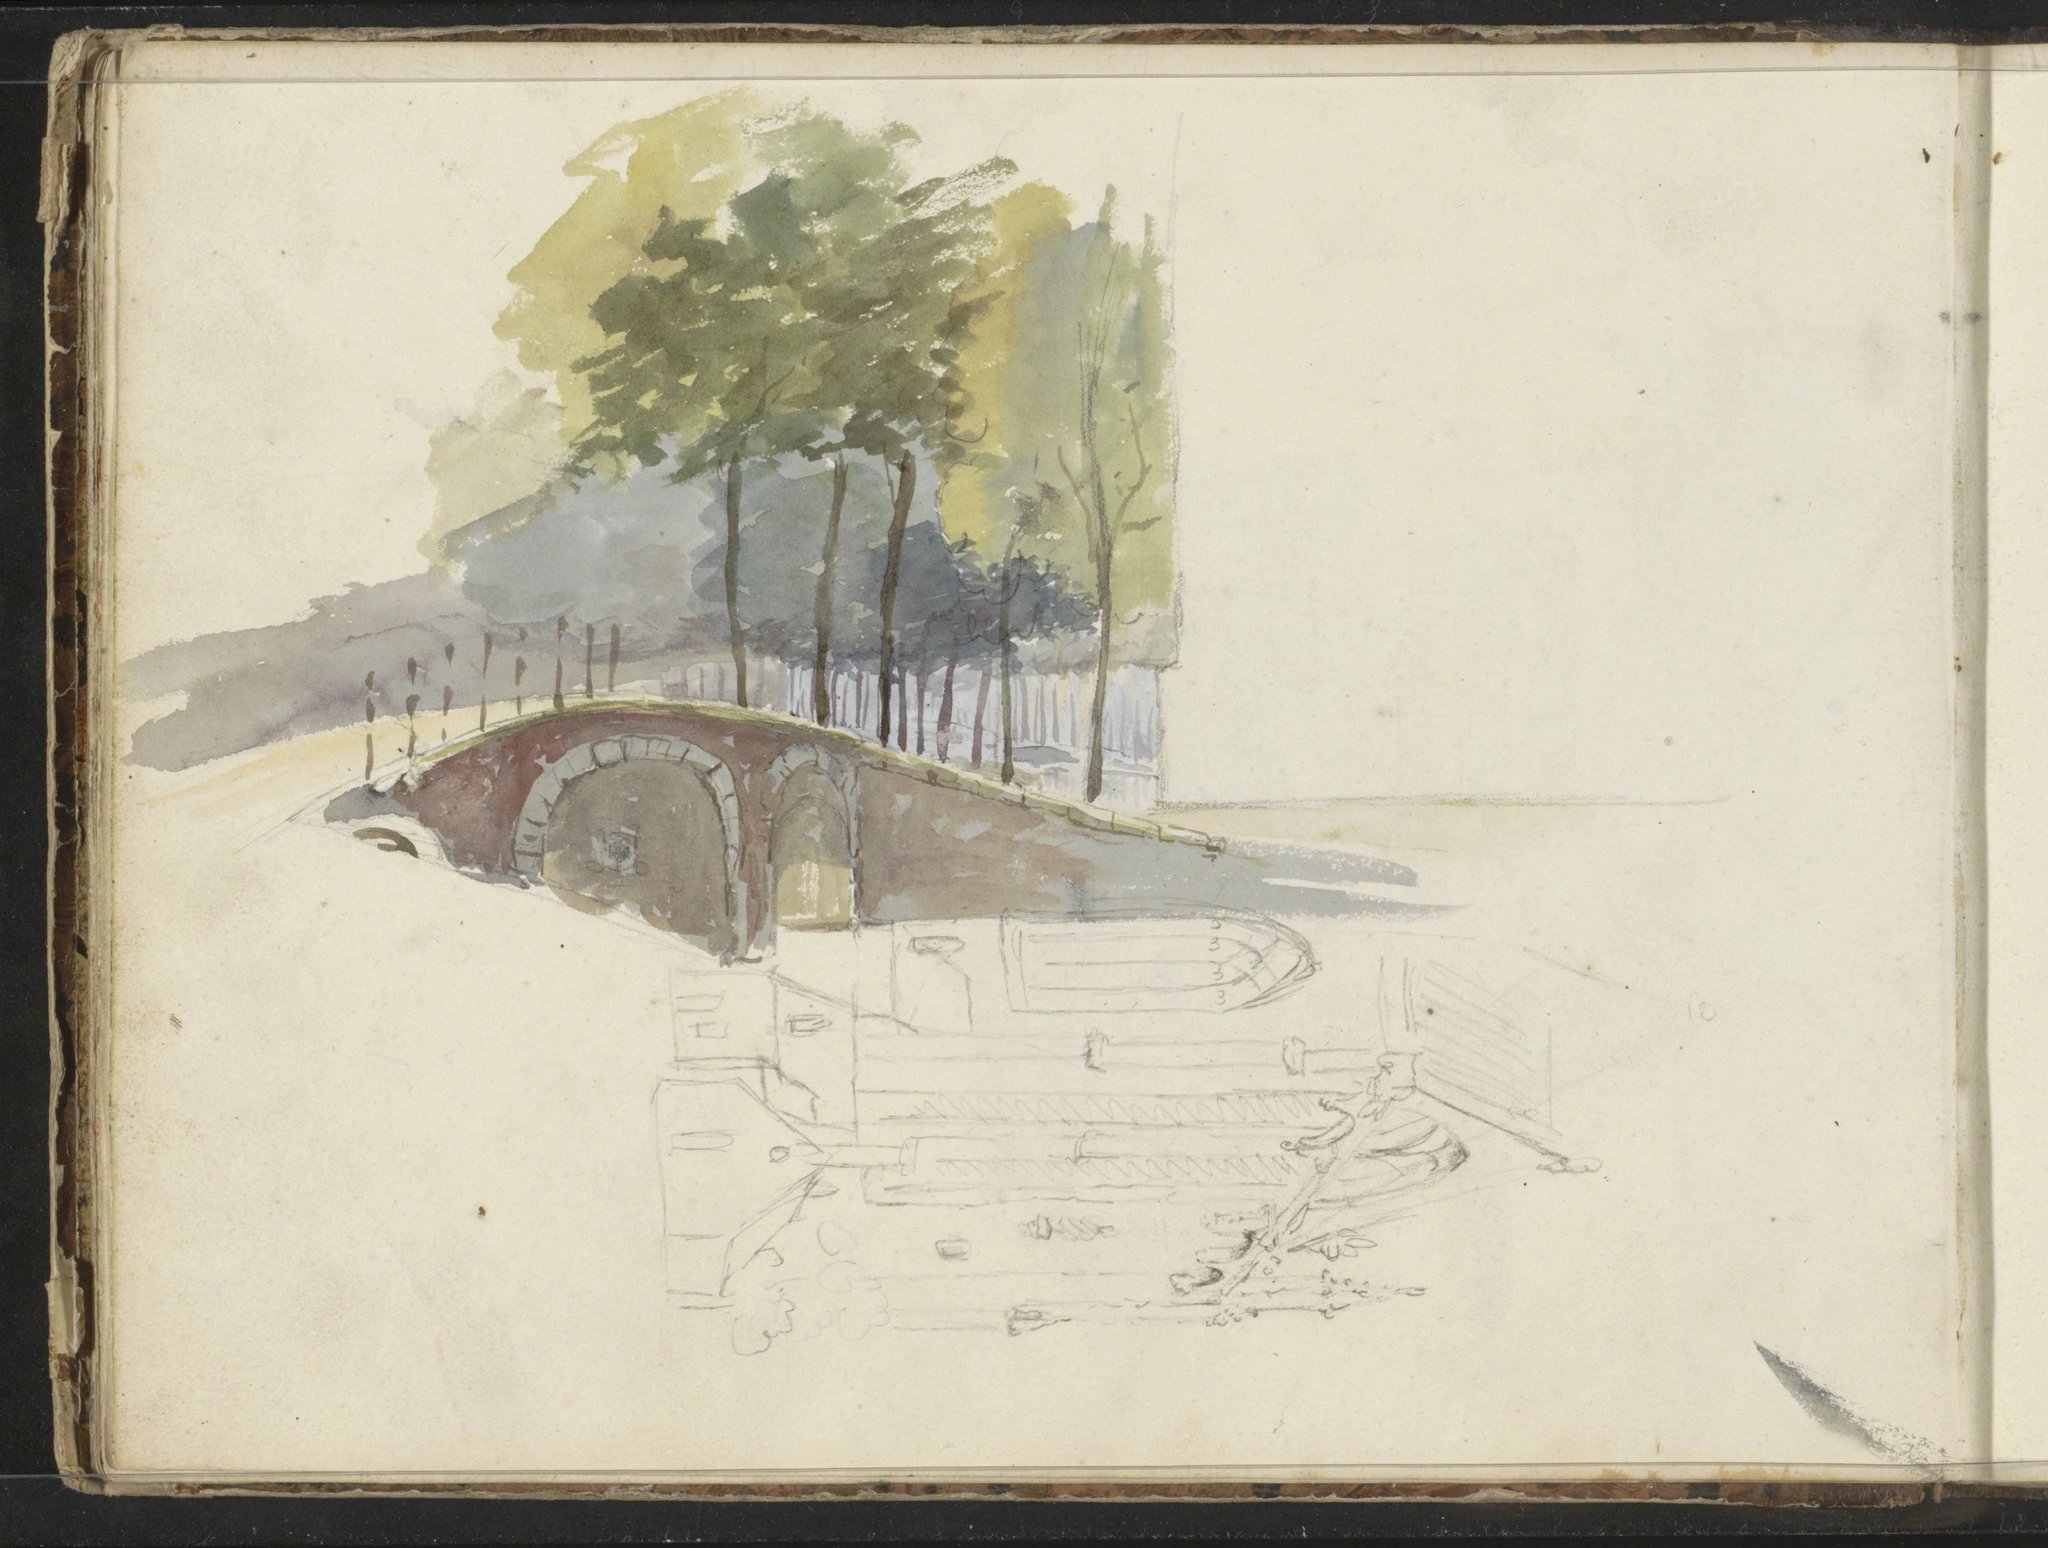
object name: sketchbook leaf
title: Exterieur van een kerk en een brug over een gracht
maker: willem troost (ii)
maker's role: draughtsman, painter, print maker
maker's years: 1812-1893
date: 1822-1893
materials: paper, pencil, watercolor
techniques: brush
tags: church (exterior), canals, waters (in city)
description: Blad 7 verso uit een schetsboek met 36 bladen.